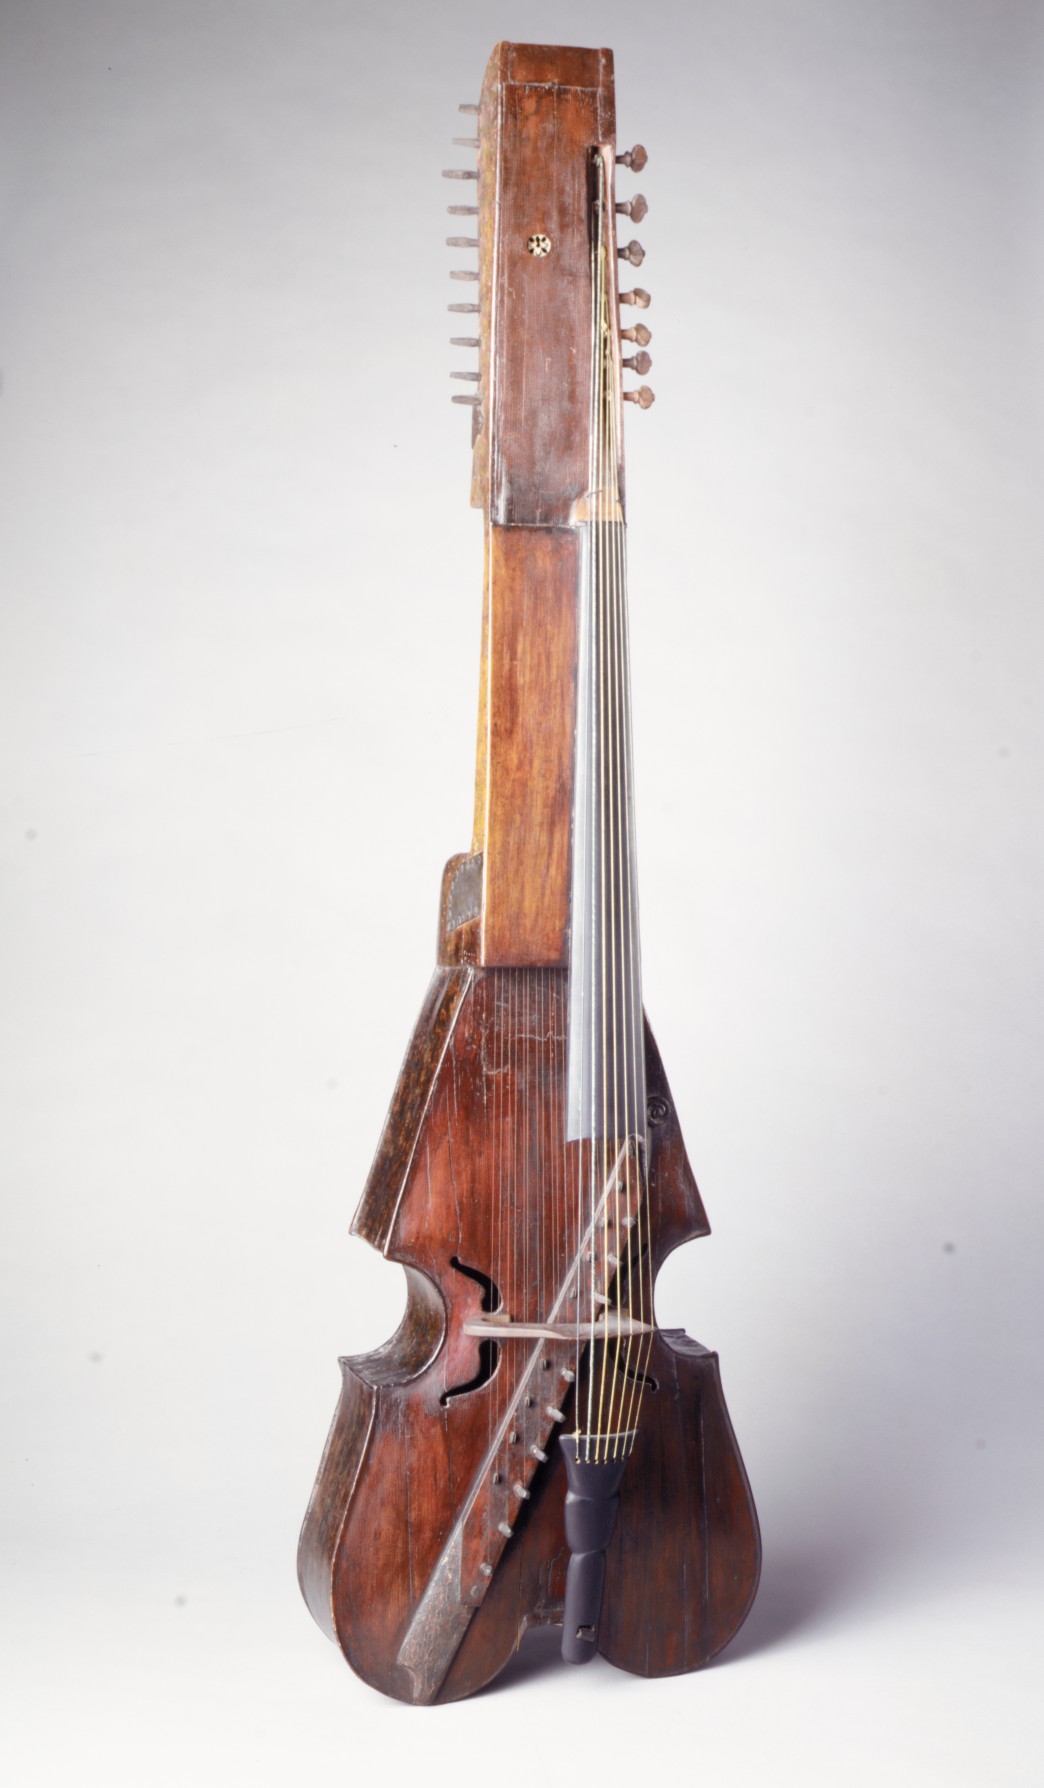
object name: baryton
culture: czech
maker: johann joseph stadlmann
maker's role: maker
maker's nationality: czech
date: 1779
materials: wood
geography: czech republic